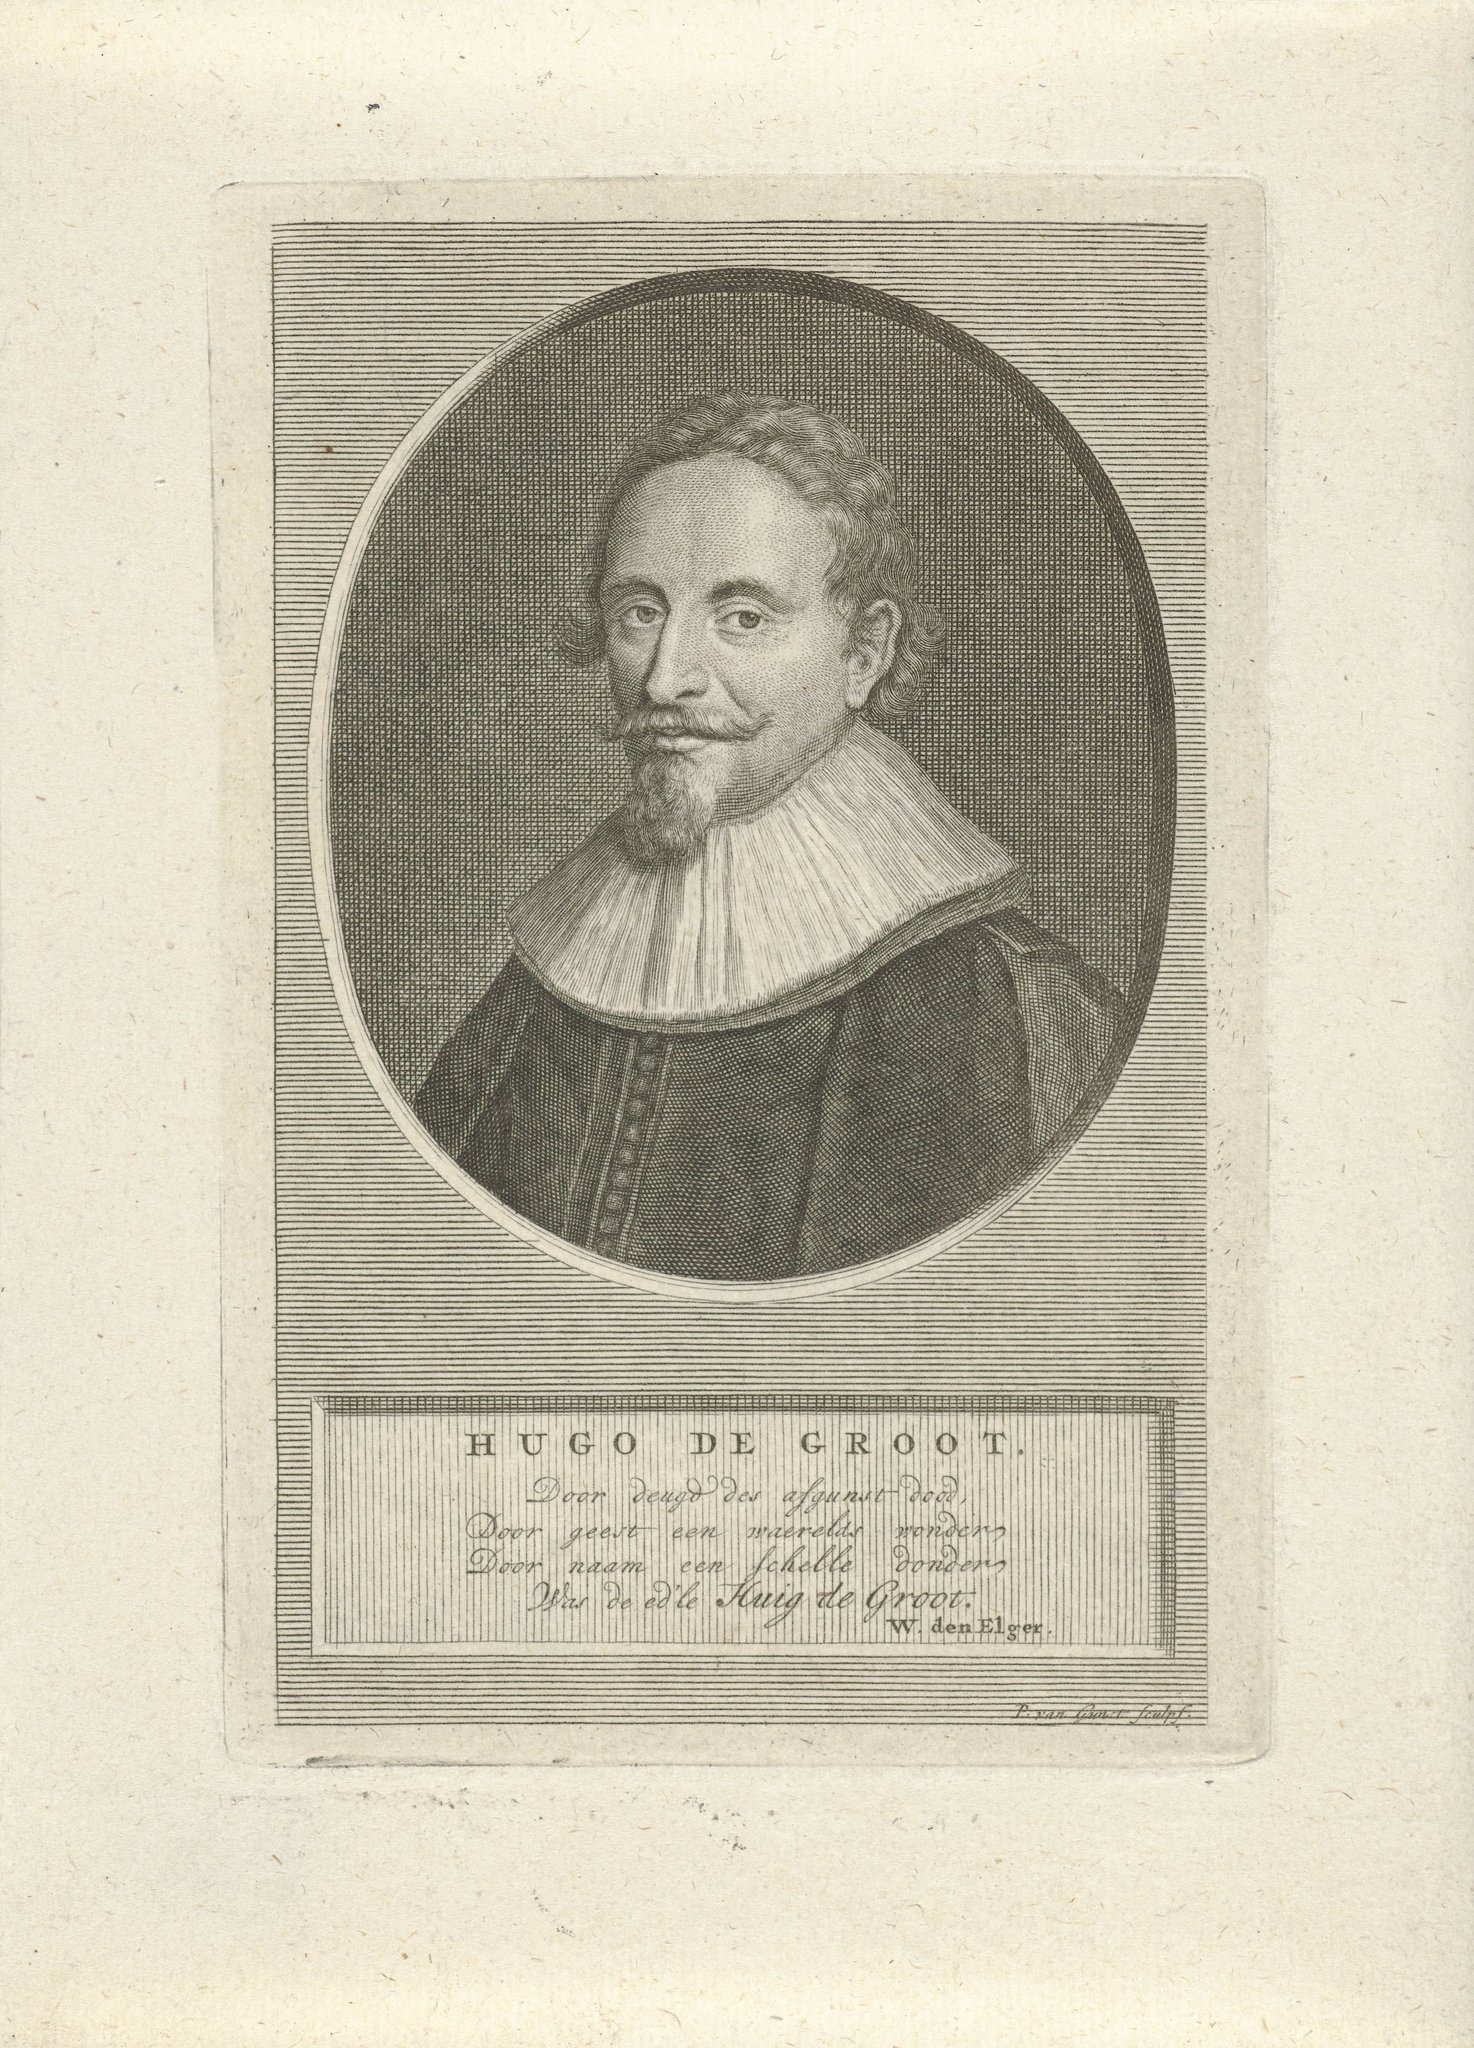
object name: print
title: Portret van Hugo de Groot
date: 1669-1731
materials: paper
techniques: engraving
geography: amsterdam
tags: delft, hugo de groot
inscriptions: collector's mark: Lugt 2228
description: Hugo de Groot, Nederlands dichter, schrijver en rechtsgeleerde. De prent heeft een Nederlands gedicht als onderschrift.